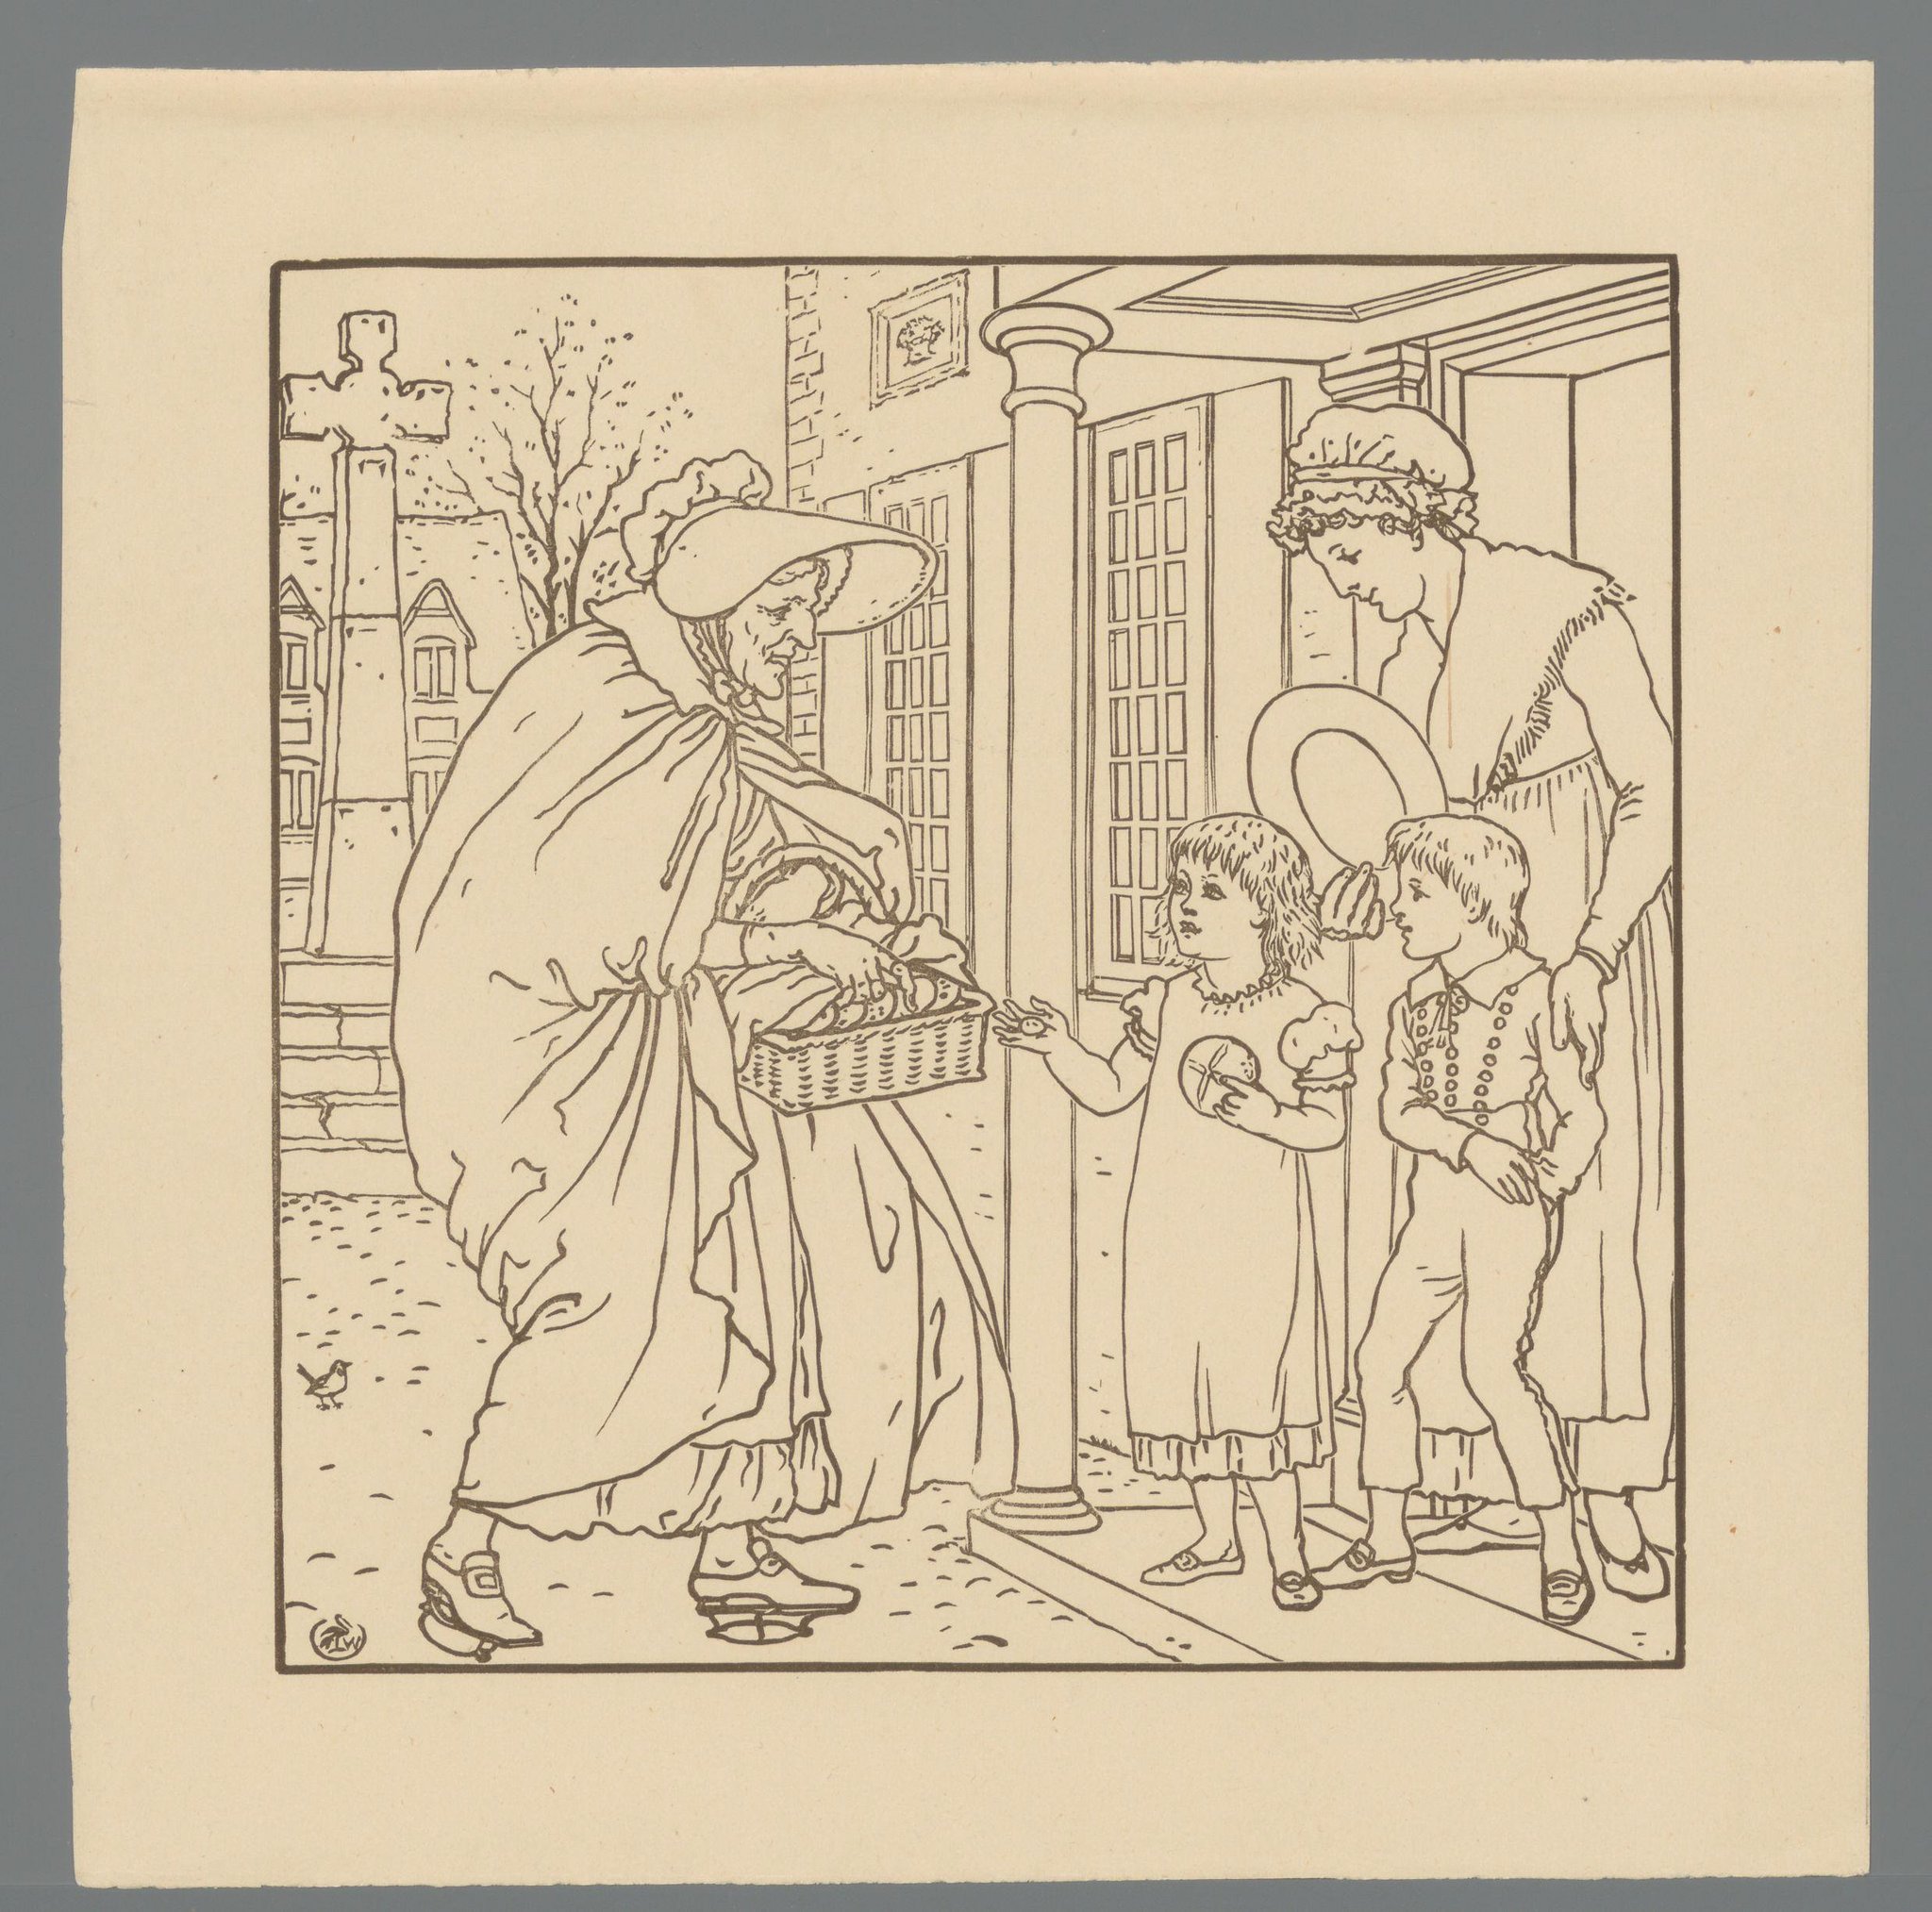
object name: print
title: Verkoopster bij een huis met vrouw en twee kinderen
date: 1887-1927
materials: paper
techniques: engraving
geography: london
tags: old woman, buying and selling, mother and child(ren), woman and child(ren) (family group)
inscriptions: collector's mark: Lugt 2228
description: Prent uit: Walter Crane's painting book. Londen: Routledge & Sons, 1887. Of een latere uitgave. Dit boek bevat twaalf voorstellingen die in kleur en lijntekening zijn gedrukt om te gebruiken als (in)kleurboek. De voorstellingen zijn afkomstig uit eerdere werken van Crane.